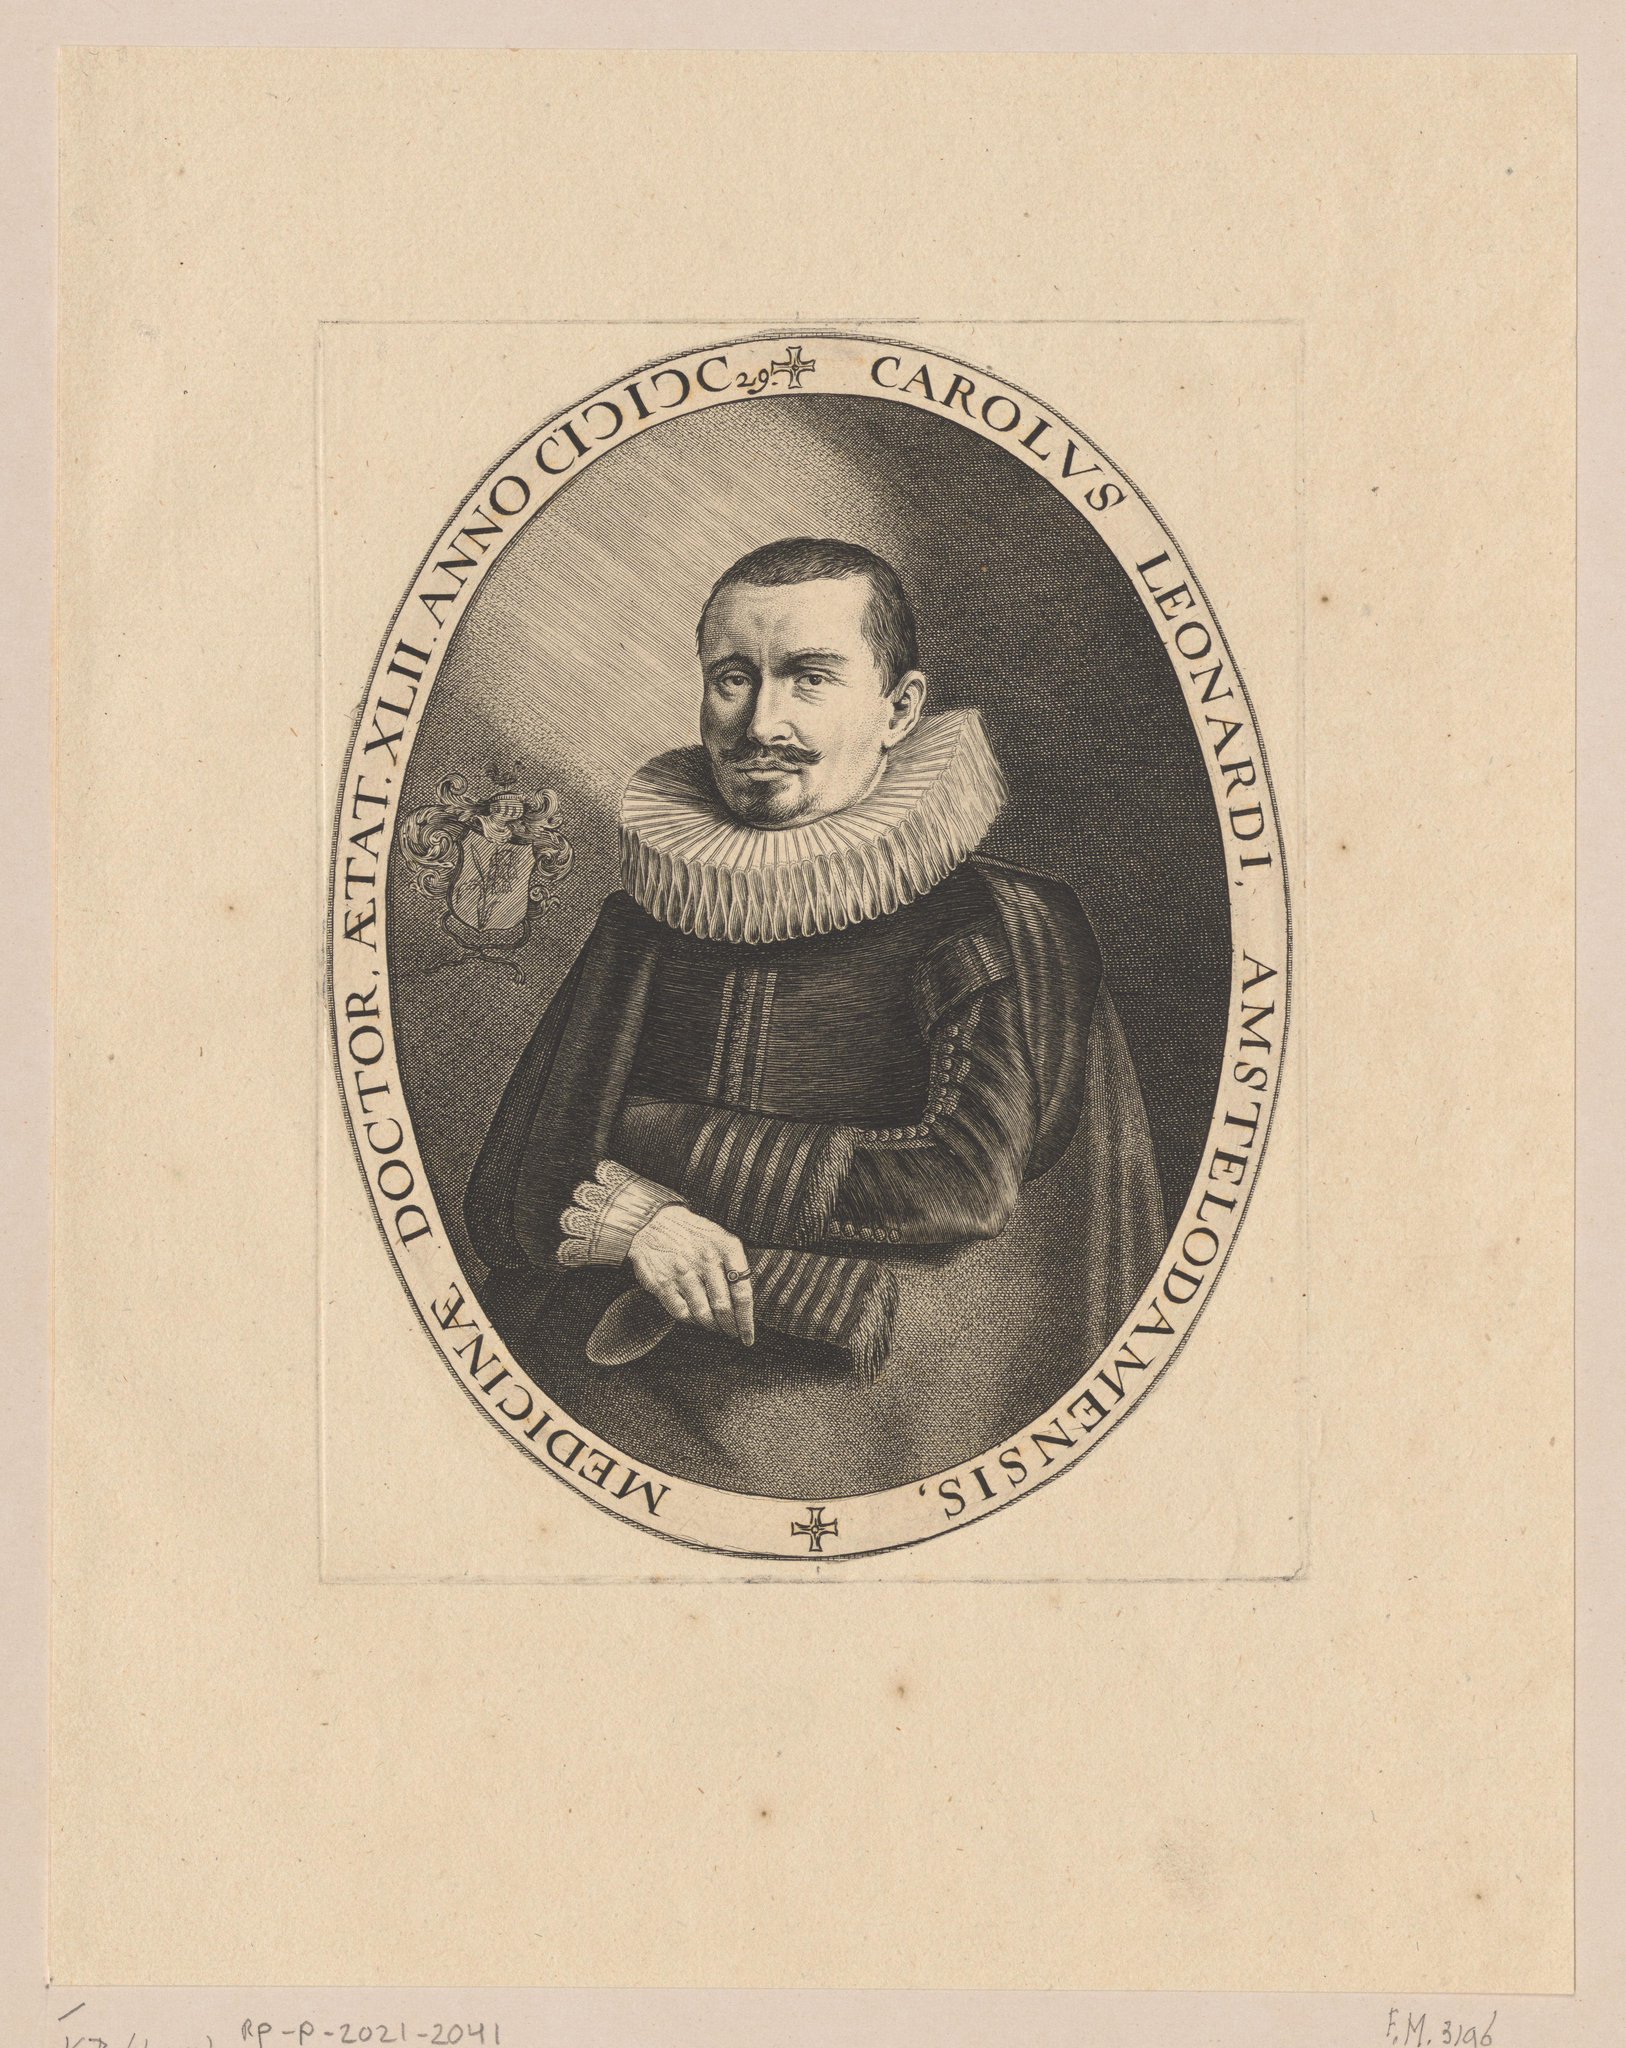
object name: print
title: Portret van Carolus Leonardi op 42-jarige leeftijd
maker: jan van de velde (ii)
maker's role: draughtsman, painter, print maker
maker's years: 1593-1641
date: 1629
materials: paper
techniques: blind stamped, engraving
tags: historical persons, physician, doctor (+ portrait of scholar, scientist), armorial bearing, heraldry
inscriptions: collector's mark: Lugt 240, collector's mark: Lugt 698